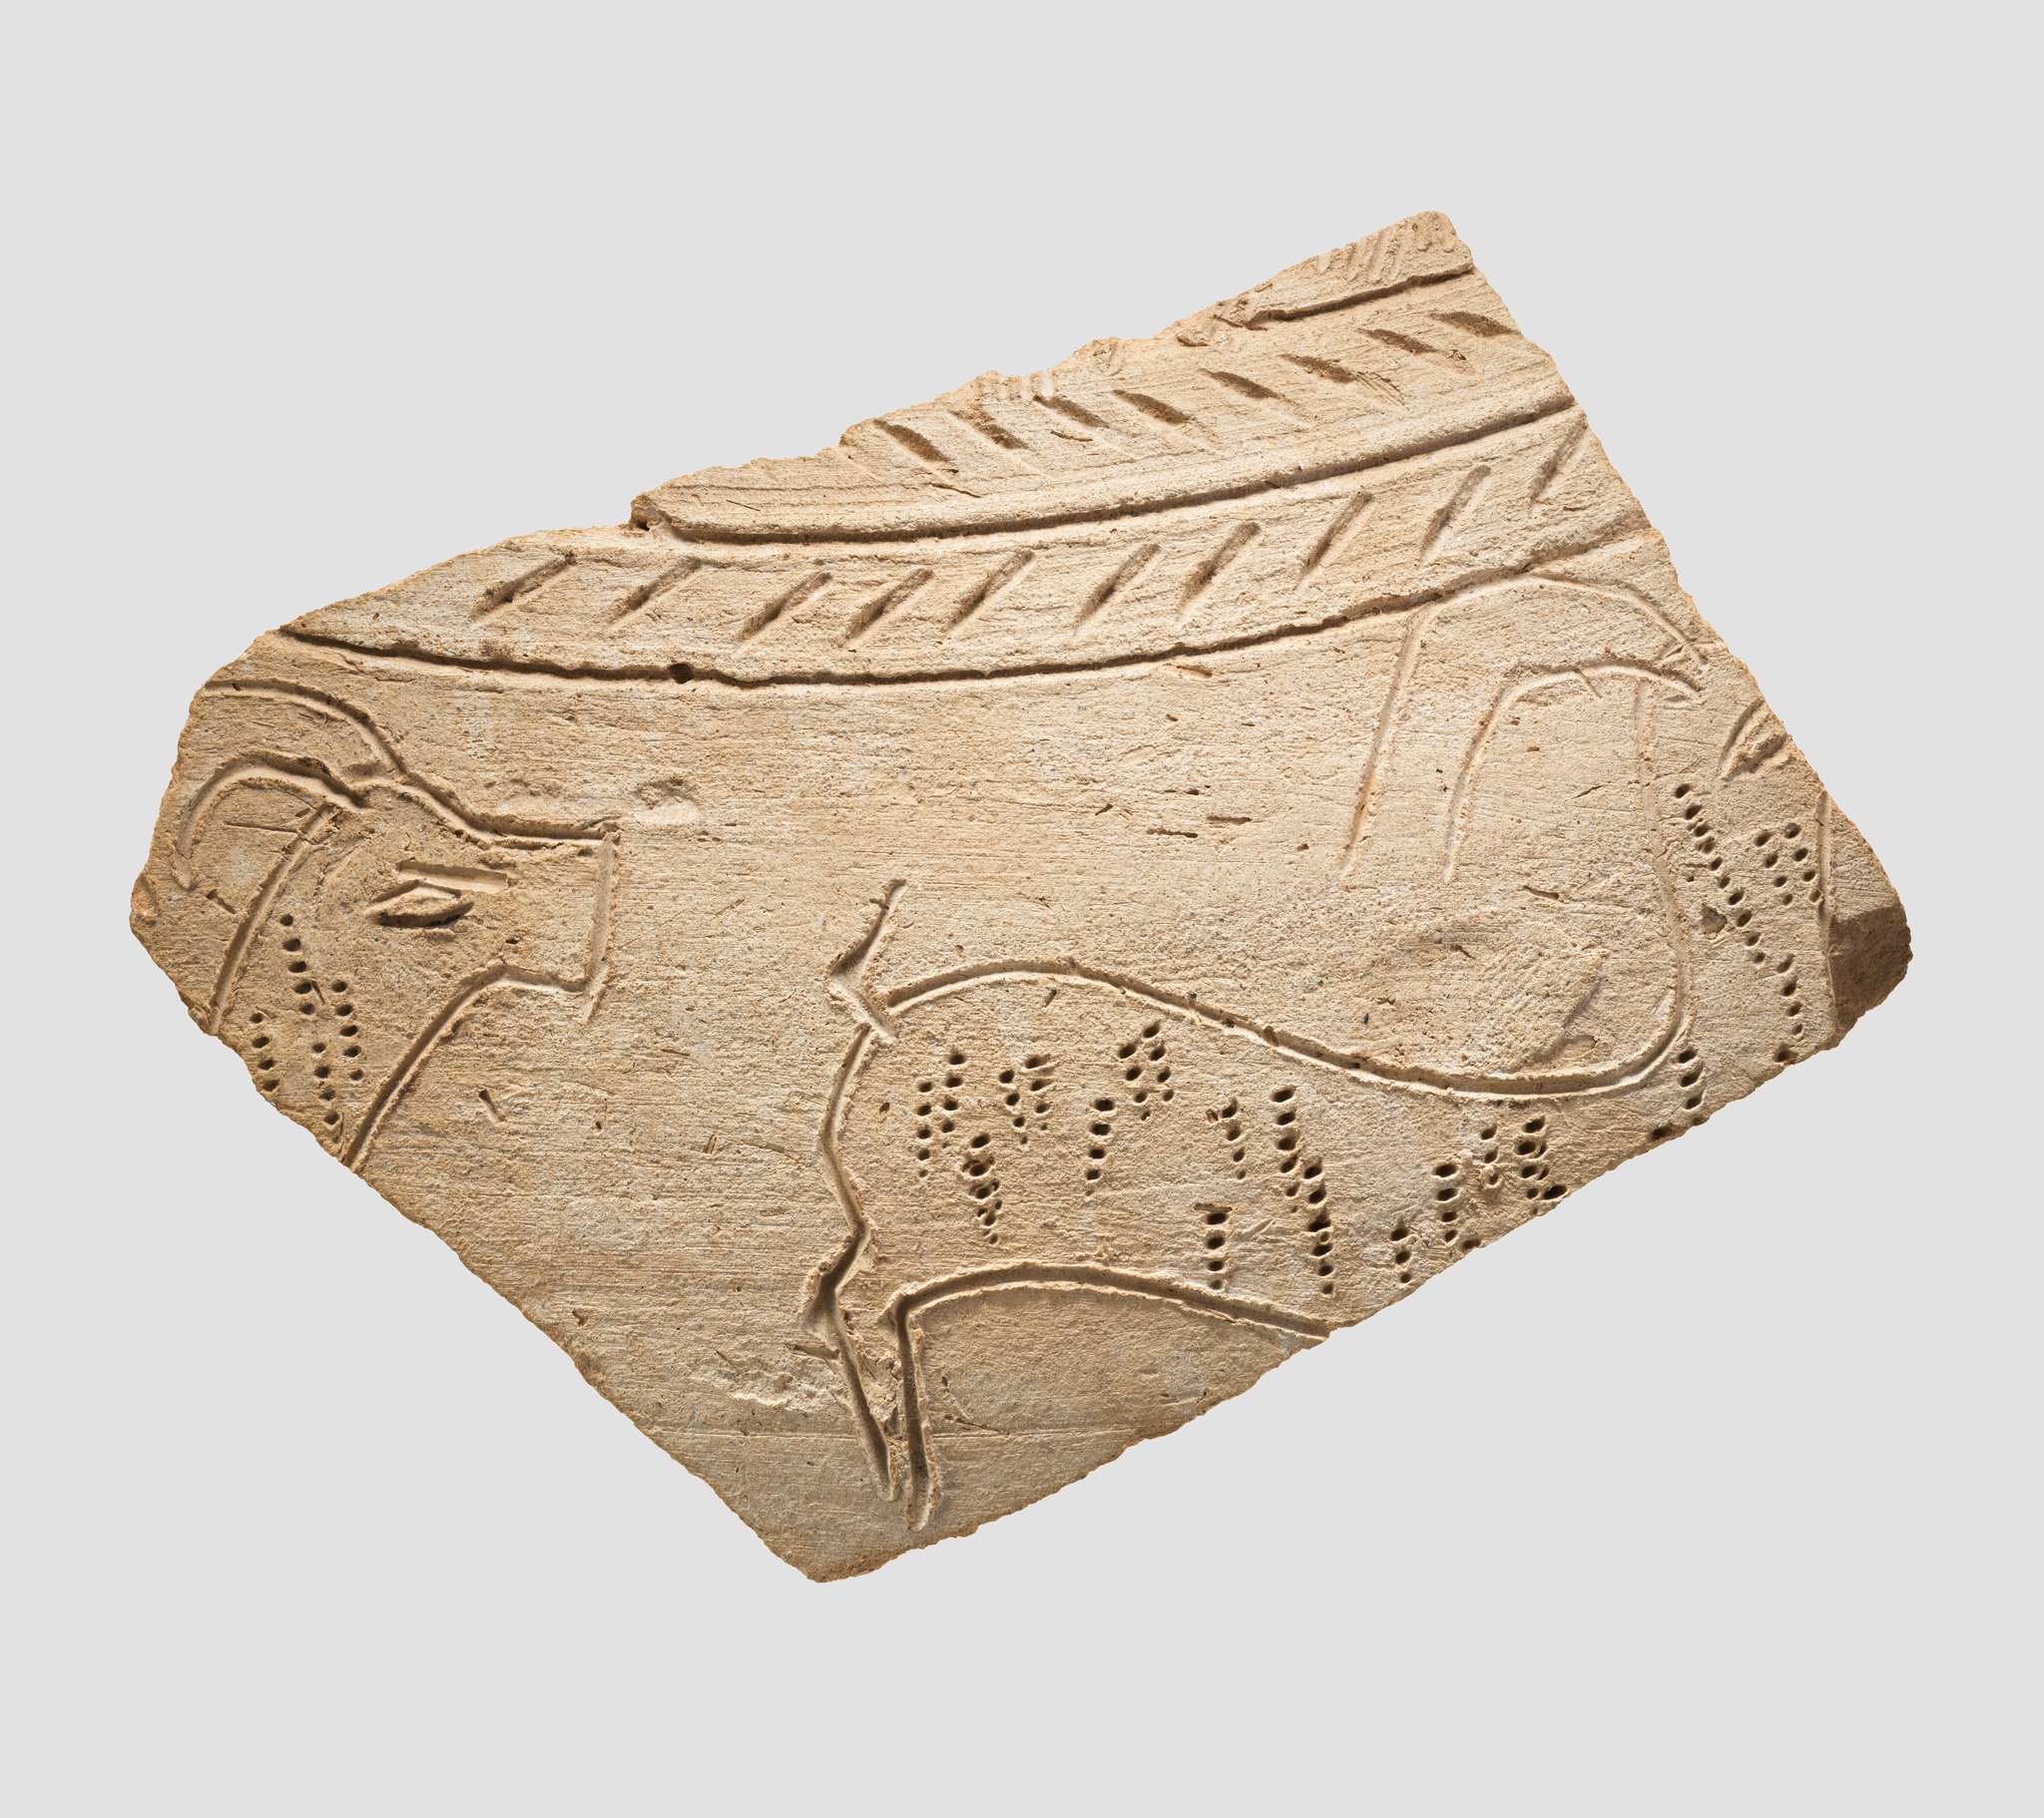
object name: sherd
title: Sherd with incised decoration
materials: ceramic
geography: mesopotamia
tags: animals